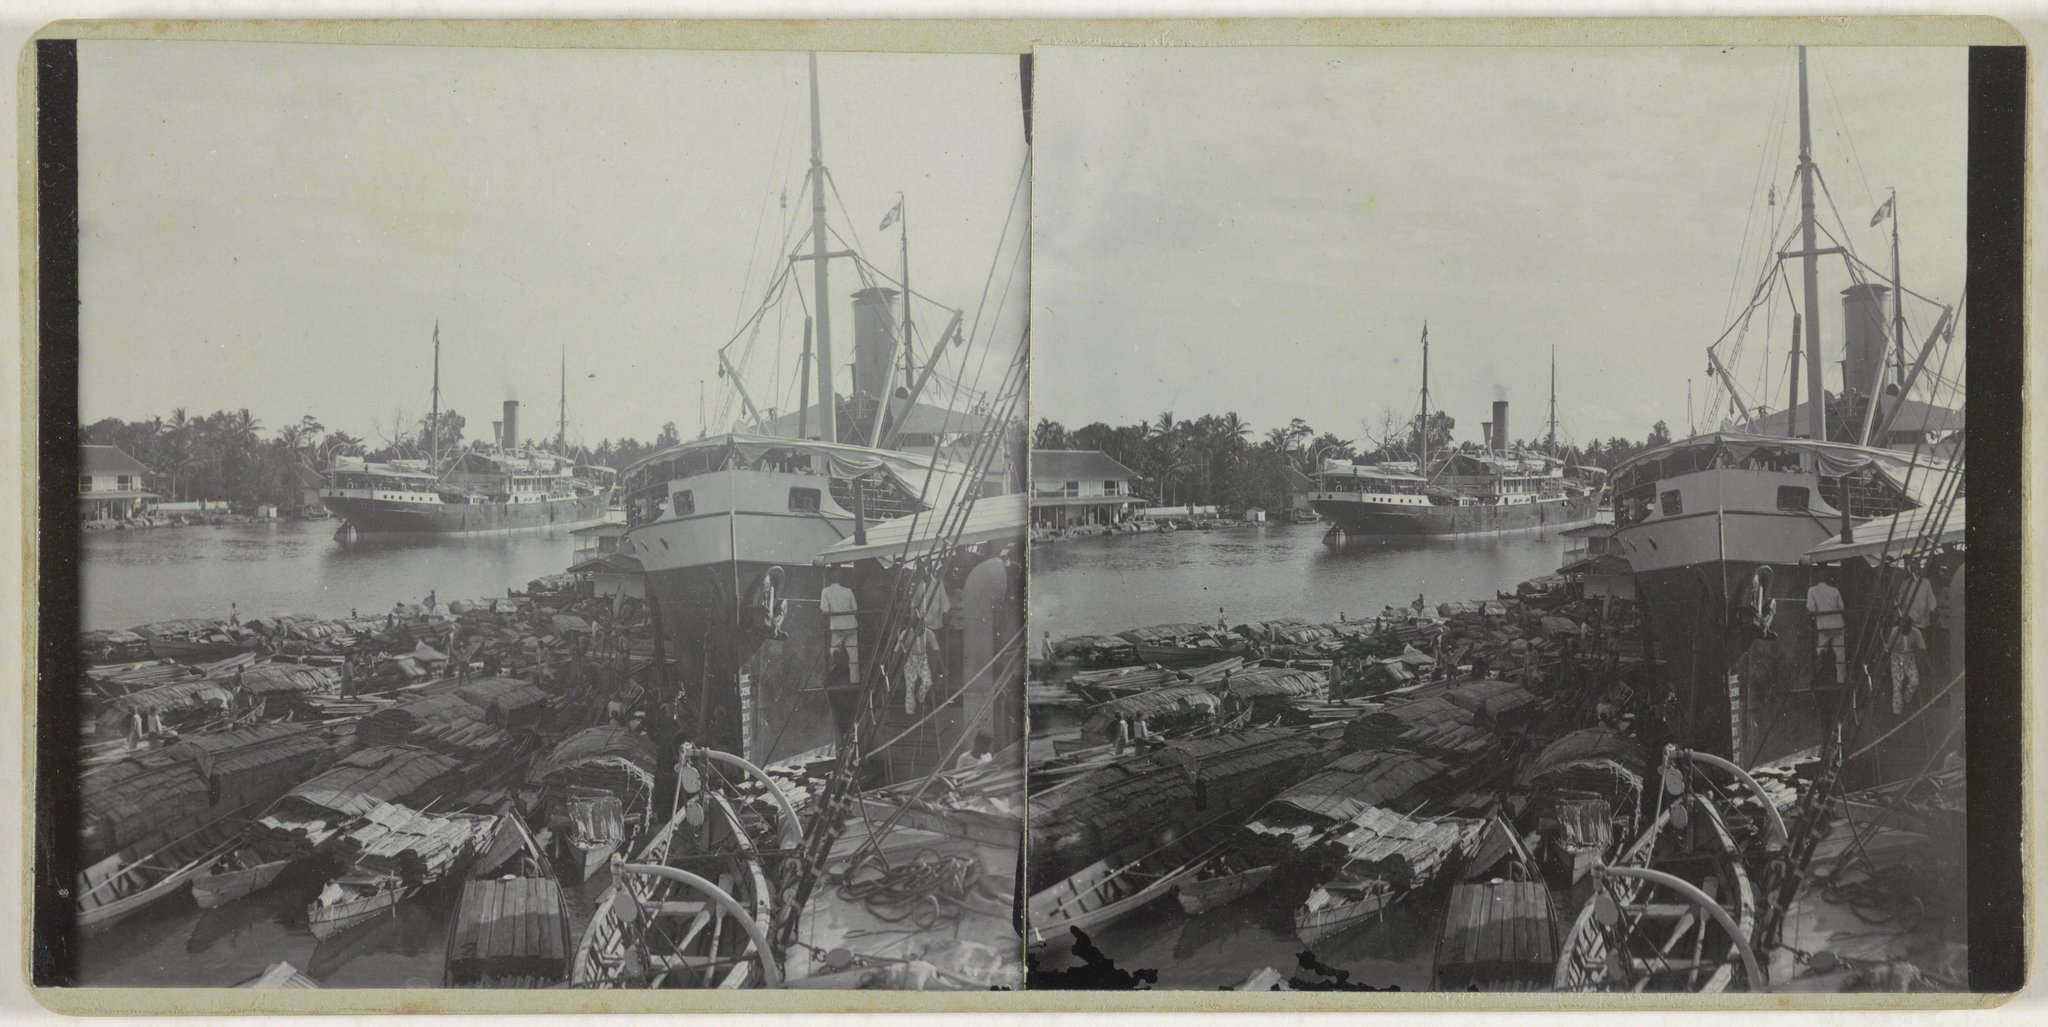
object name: stereograph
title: Gezicht op een haven in Indonesië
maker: Anonymous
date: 1890-1930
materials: paper, cardboard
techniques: gelatin silver print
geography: indonesia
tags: harbour, indonesia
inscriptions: inscription: ‘B' Massin’